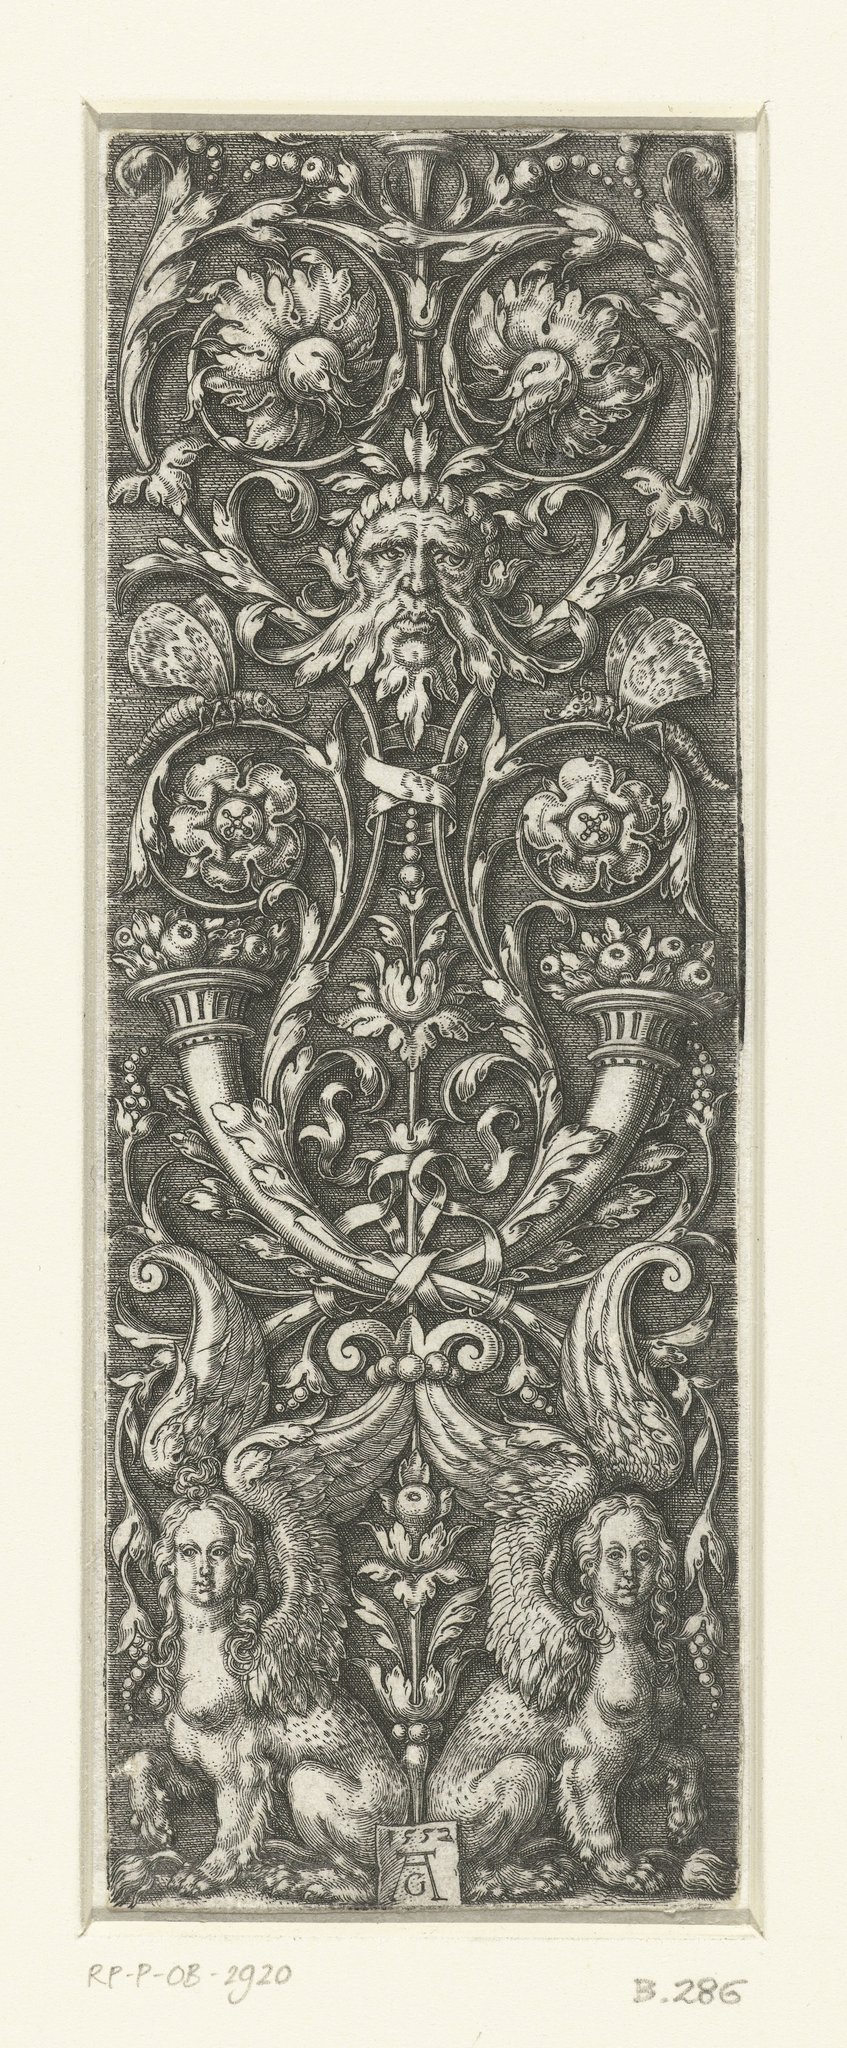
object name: print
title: Vlakdecoratie met bladranken en grotesken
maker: heinrich aldegrever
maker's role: draughtsman, print maker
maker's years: 1502-1561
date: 1552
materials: paper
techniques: engraving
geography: germany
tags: ornaments ~ art, sphinx (lion/woman); 'sfinge' (ripa)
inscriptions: number: ‘25’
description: Vlakdecoratie met onderaan twee sfinxen. Daarboven kruisen zich twee hoorns des overvloeds en symmetrisch geordende bladranken. Midden boven zit een masker.